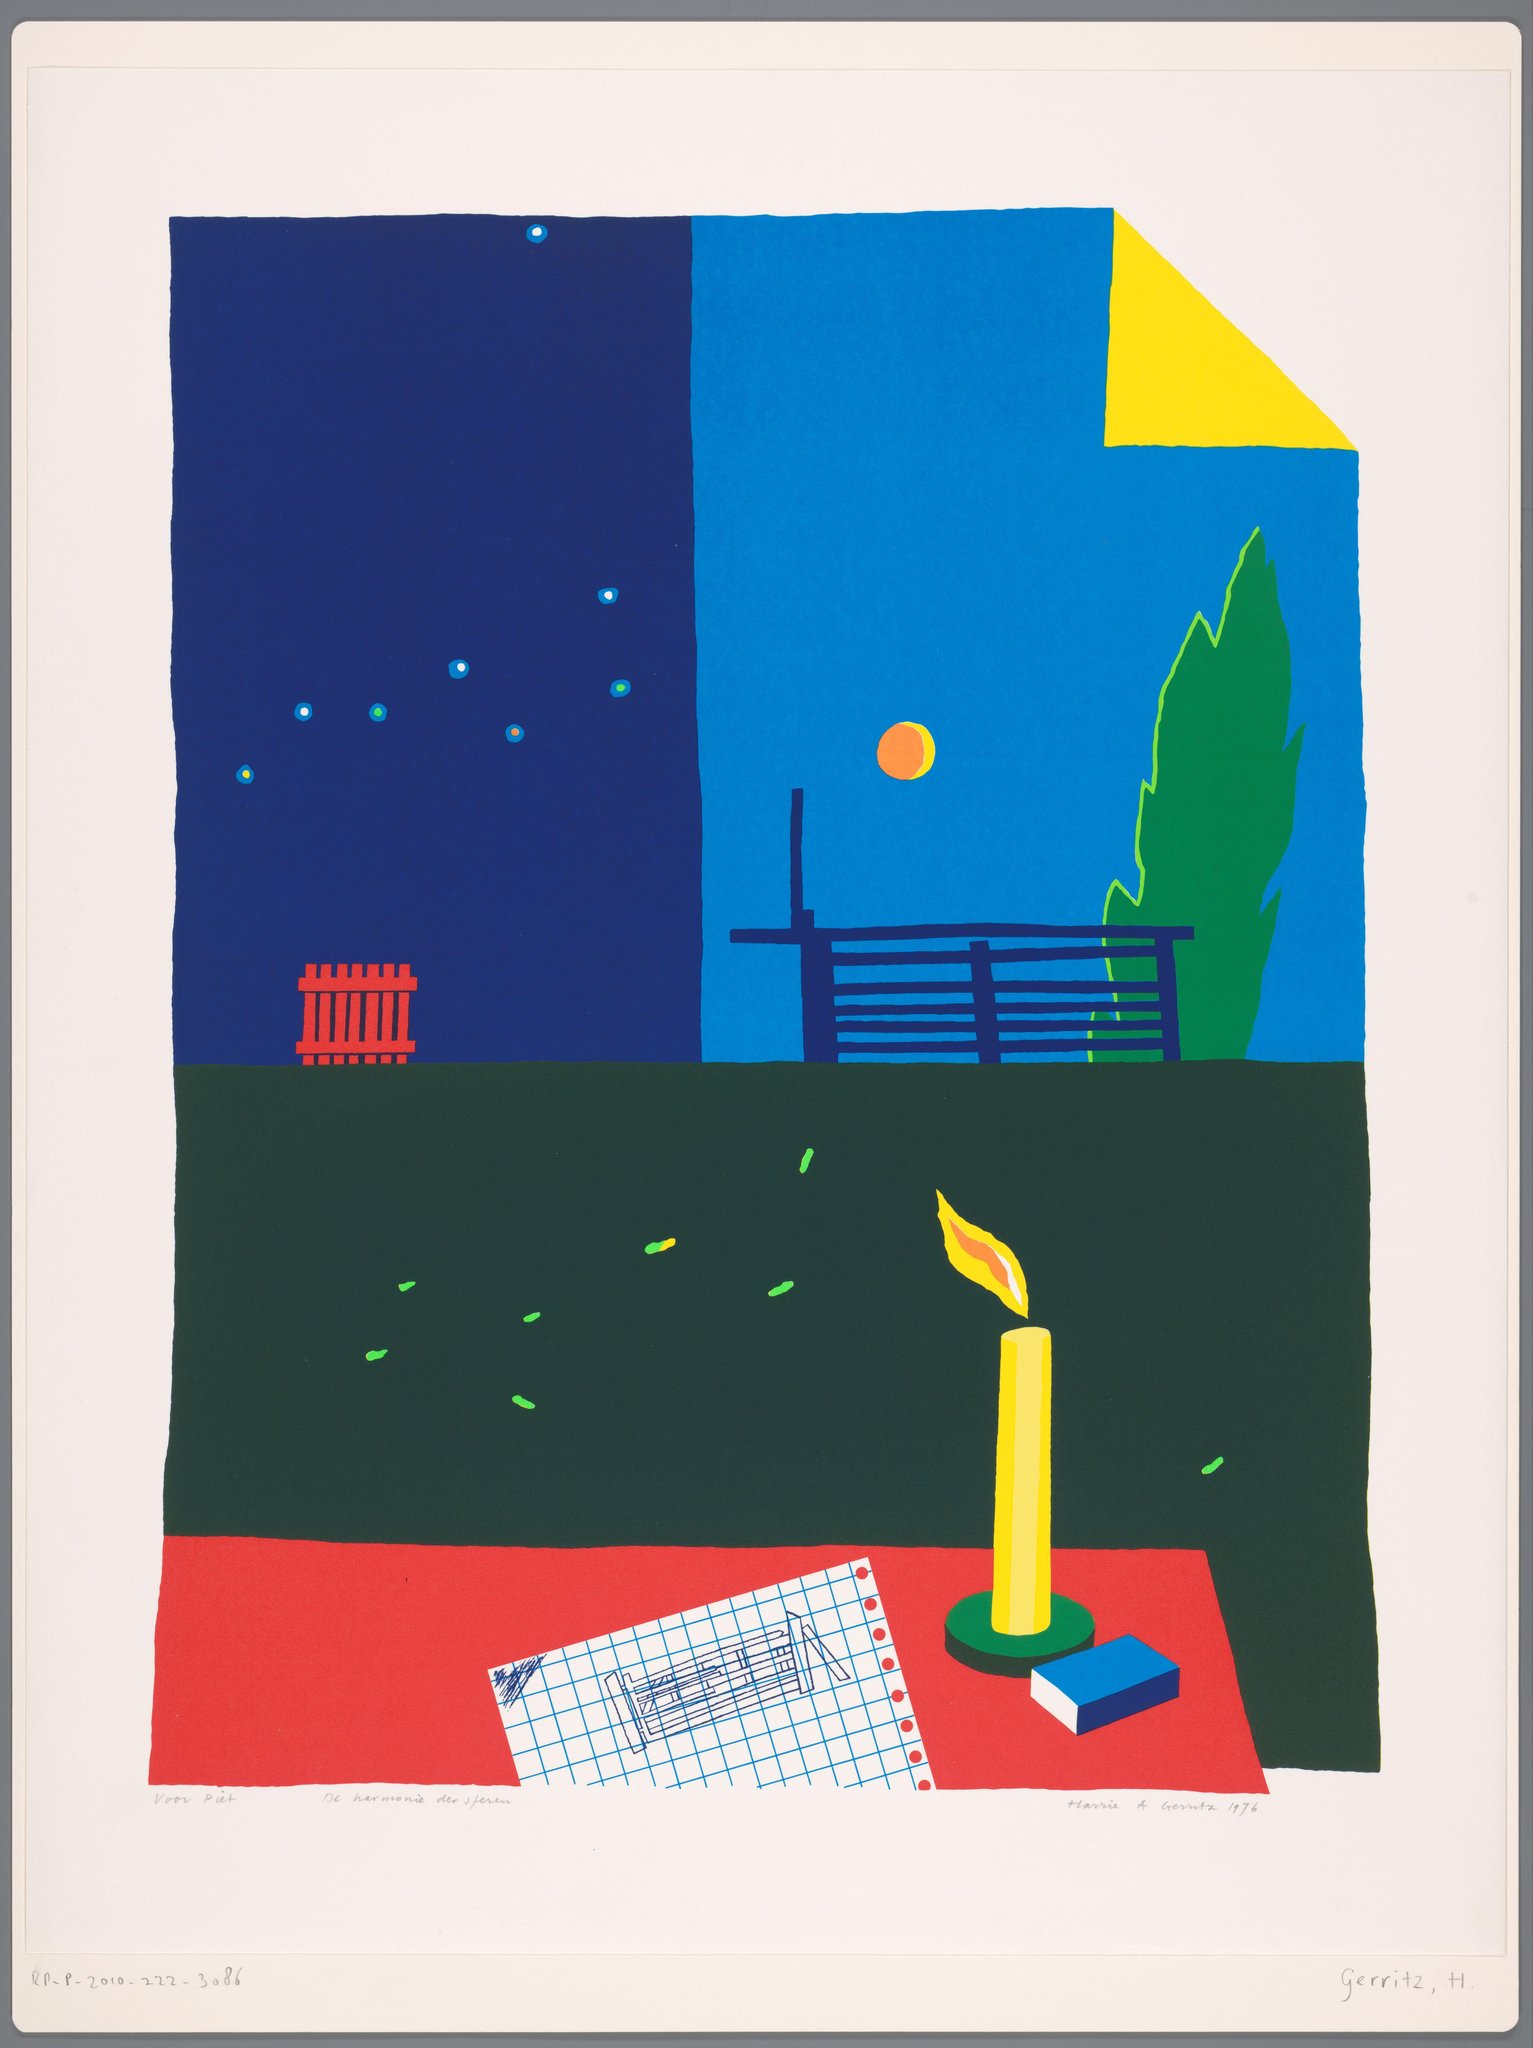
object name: print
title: De harmonie der sferen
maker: harrie a. gerritz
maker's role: draughtsman, painter, print maker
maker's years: 1940-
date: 1976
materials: paper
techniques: screen printing in color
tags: trees, candle, receiver, fence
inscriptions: dedication: ‘voor Piet’, collector's mark: Lugt 2228, inscription: ‘Shirley’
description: Op de voorgrond een kaars op een rode tafel, met daarnaast een lucifersdoosje en een tekening van een hek. Op de achtergrond twee hekwerken in rood en blauw, bij nacht en bij dag.